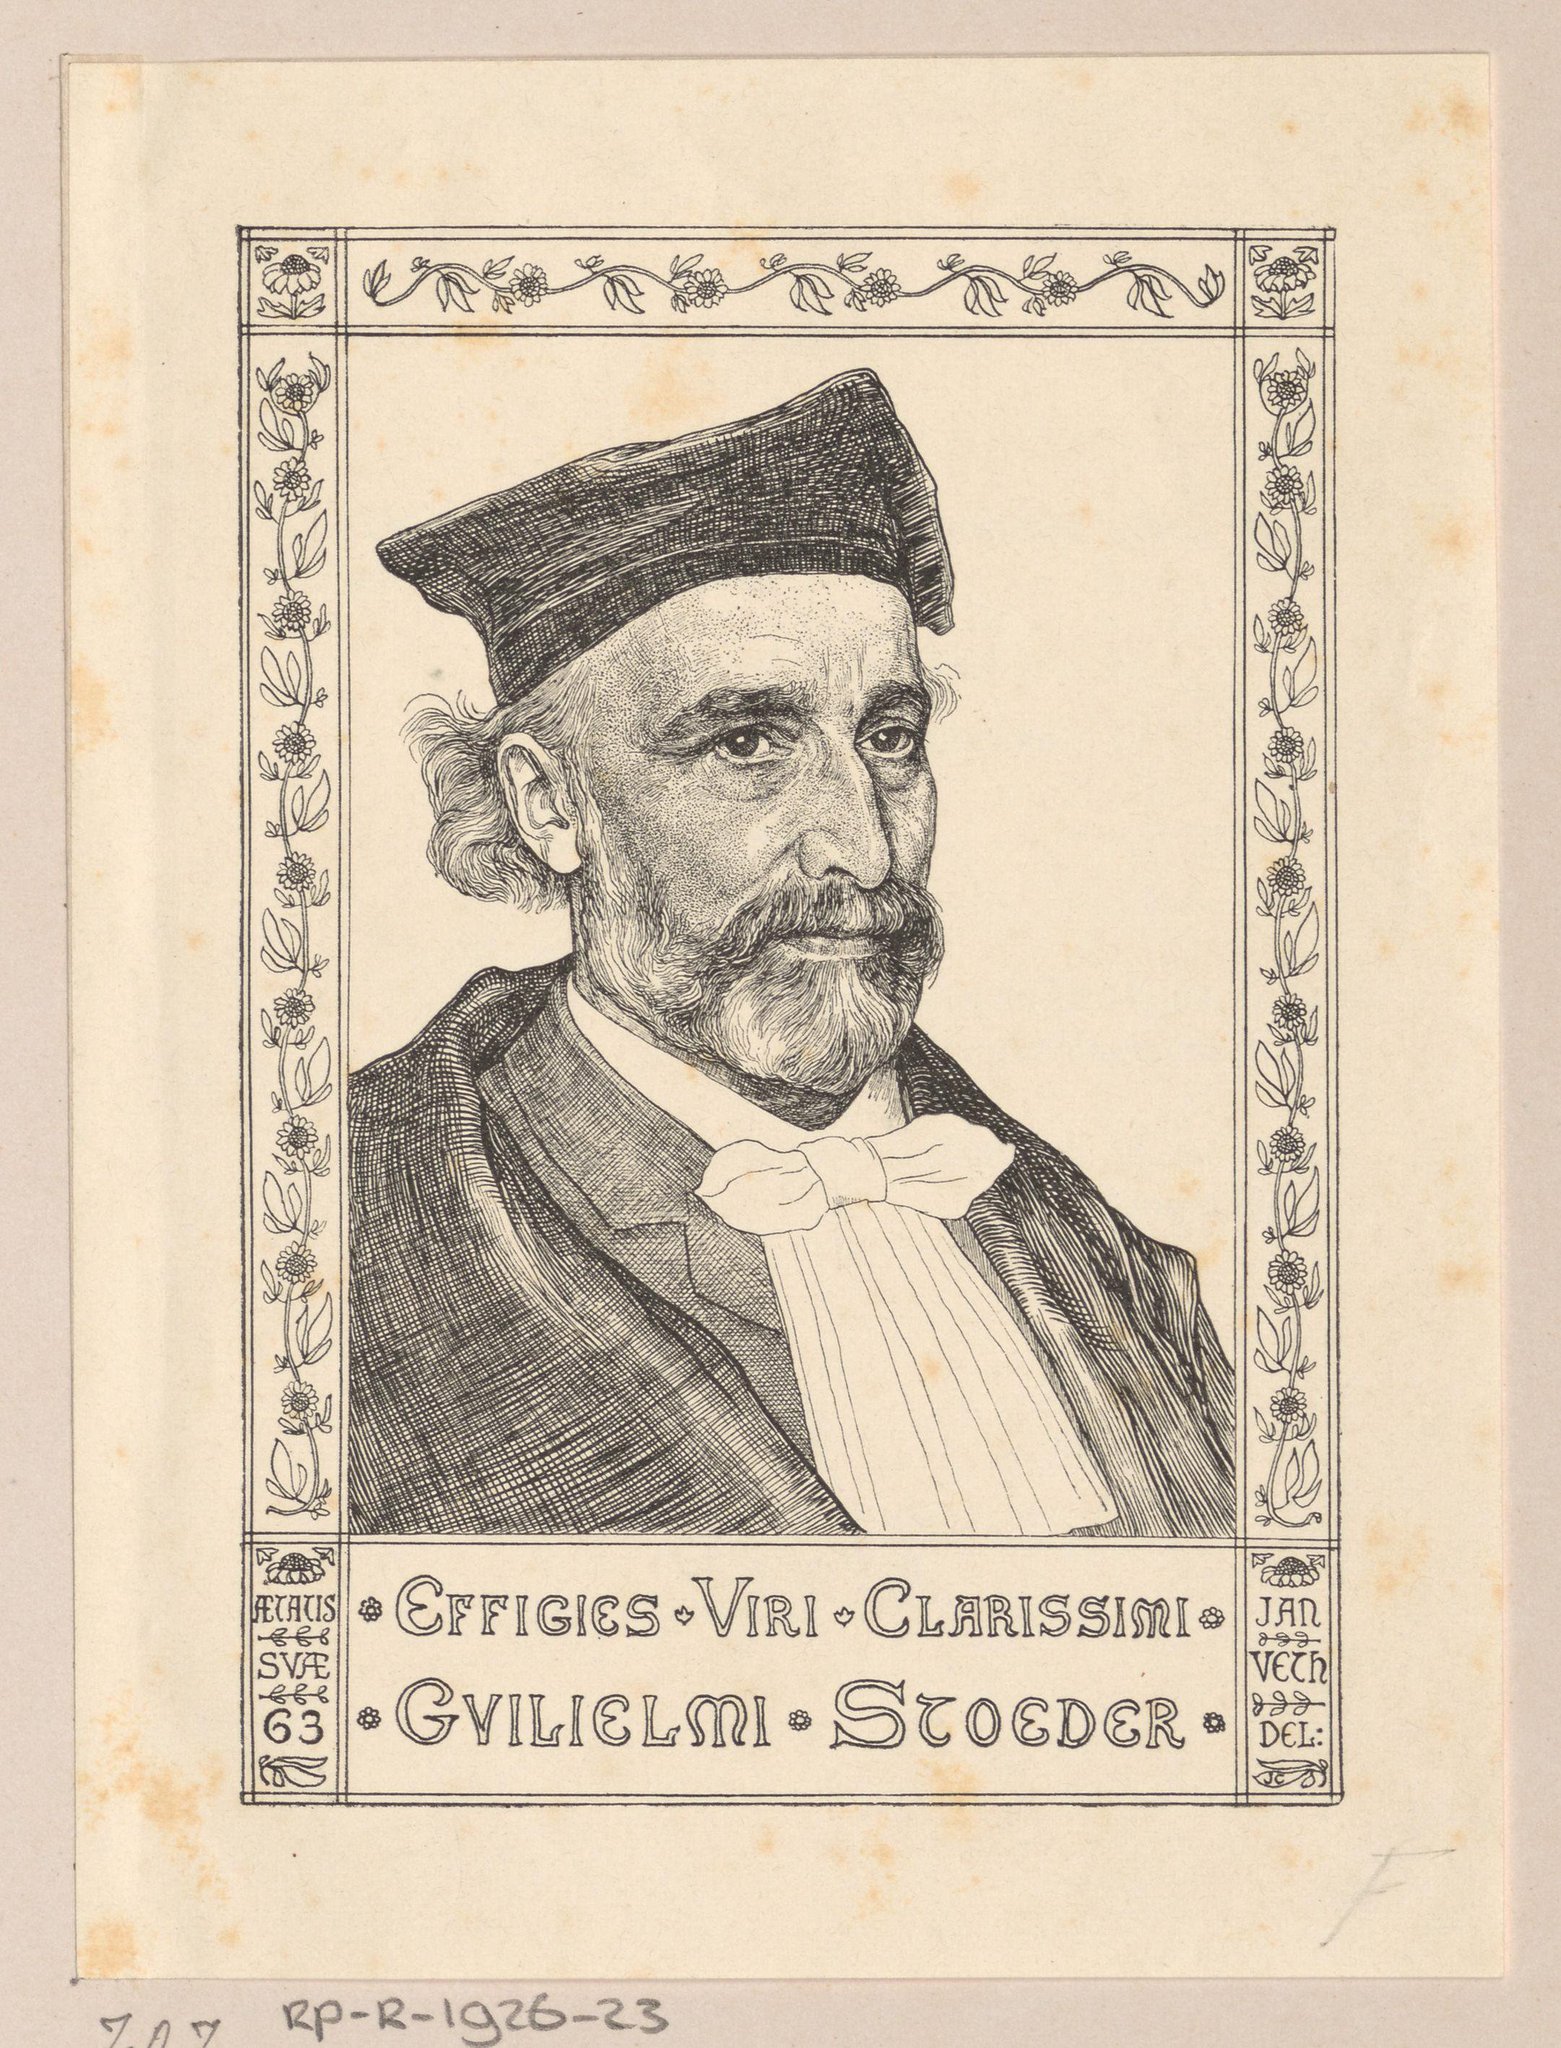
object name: photomechanical print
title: Portret van Willem Stoeder op 63-jarige leeftijd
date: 1895-1975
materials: paper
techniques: letterpress printing, line block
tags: utrecht, historical persons, professor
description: Aan de prent is een blad met tekst over een uitgave van een jaarboekje in 1895 geplakt.